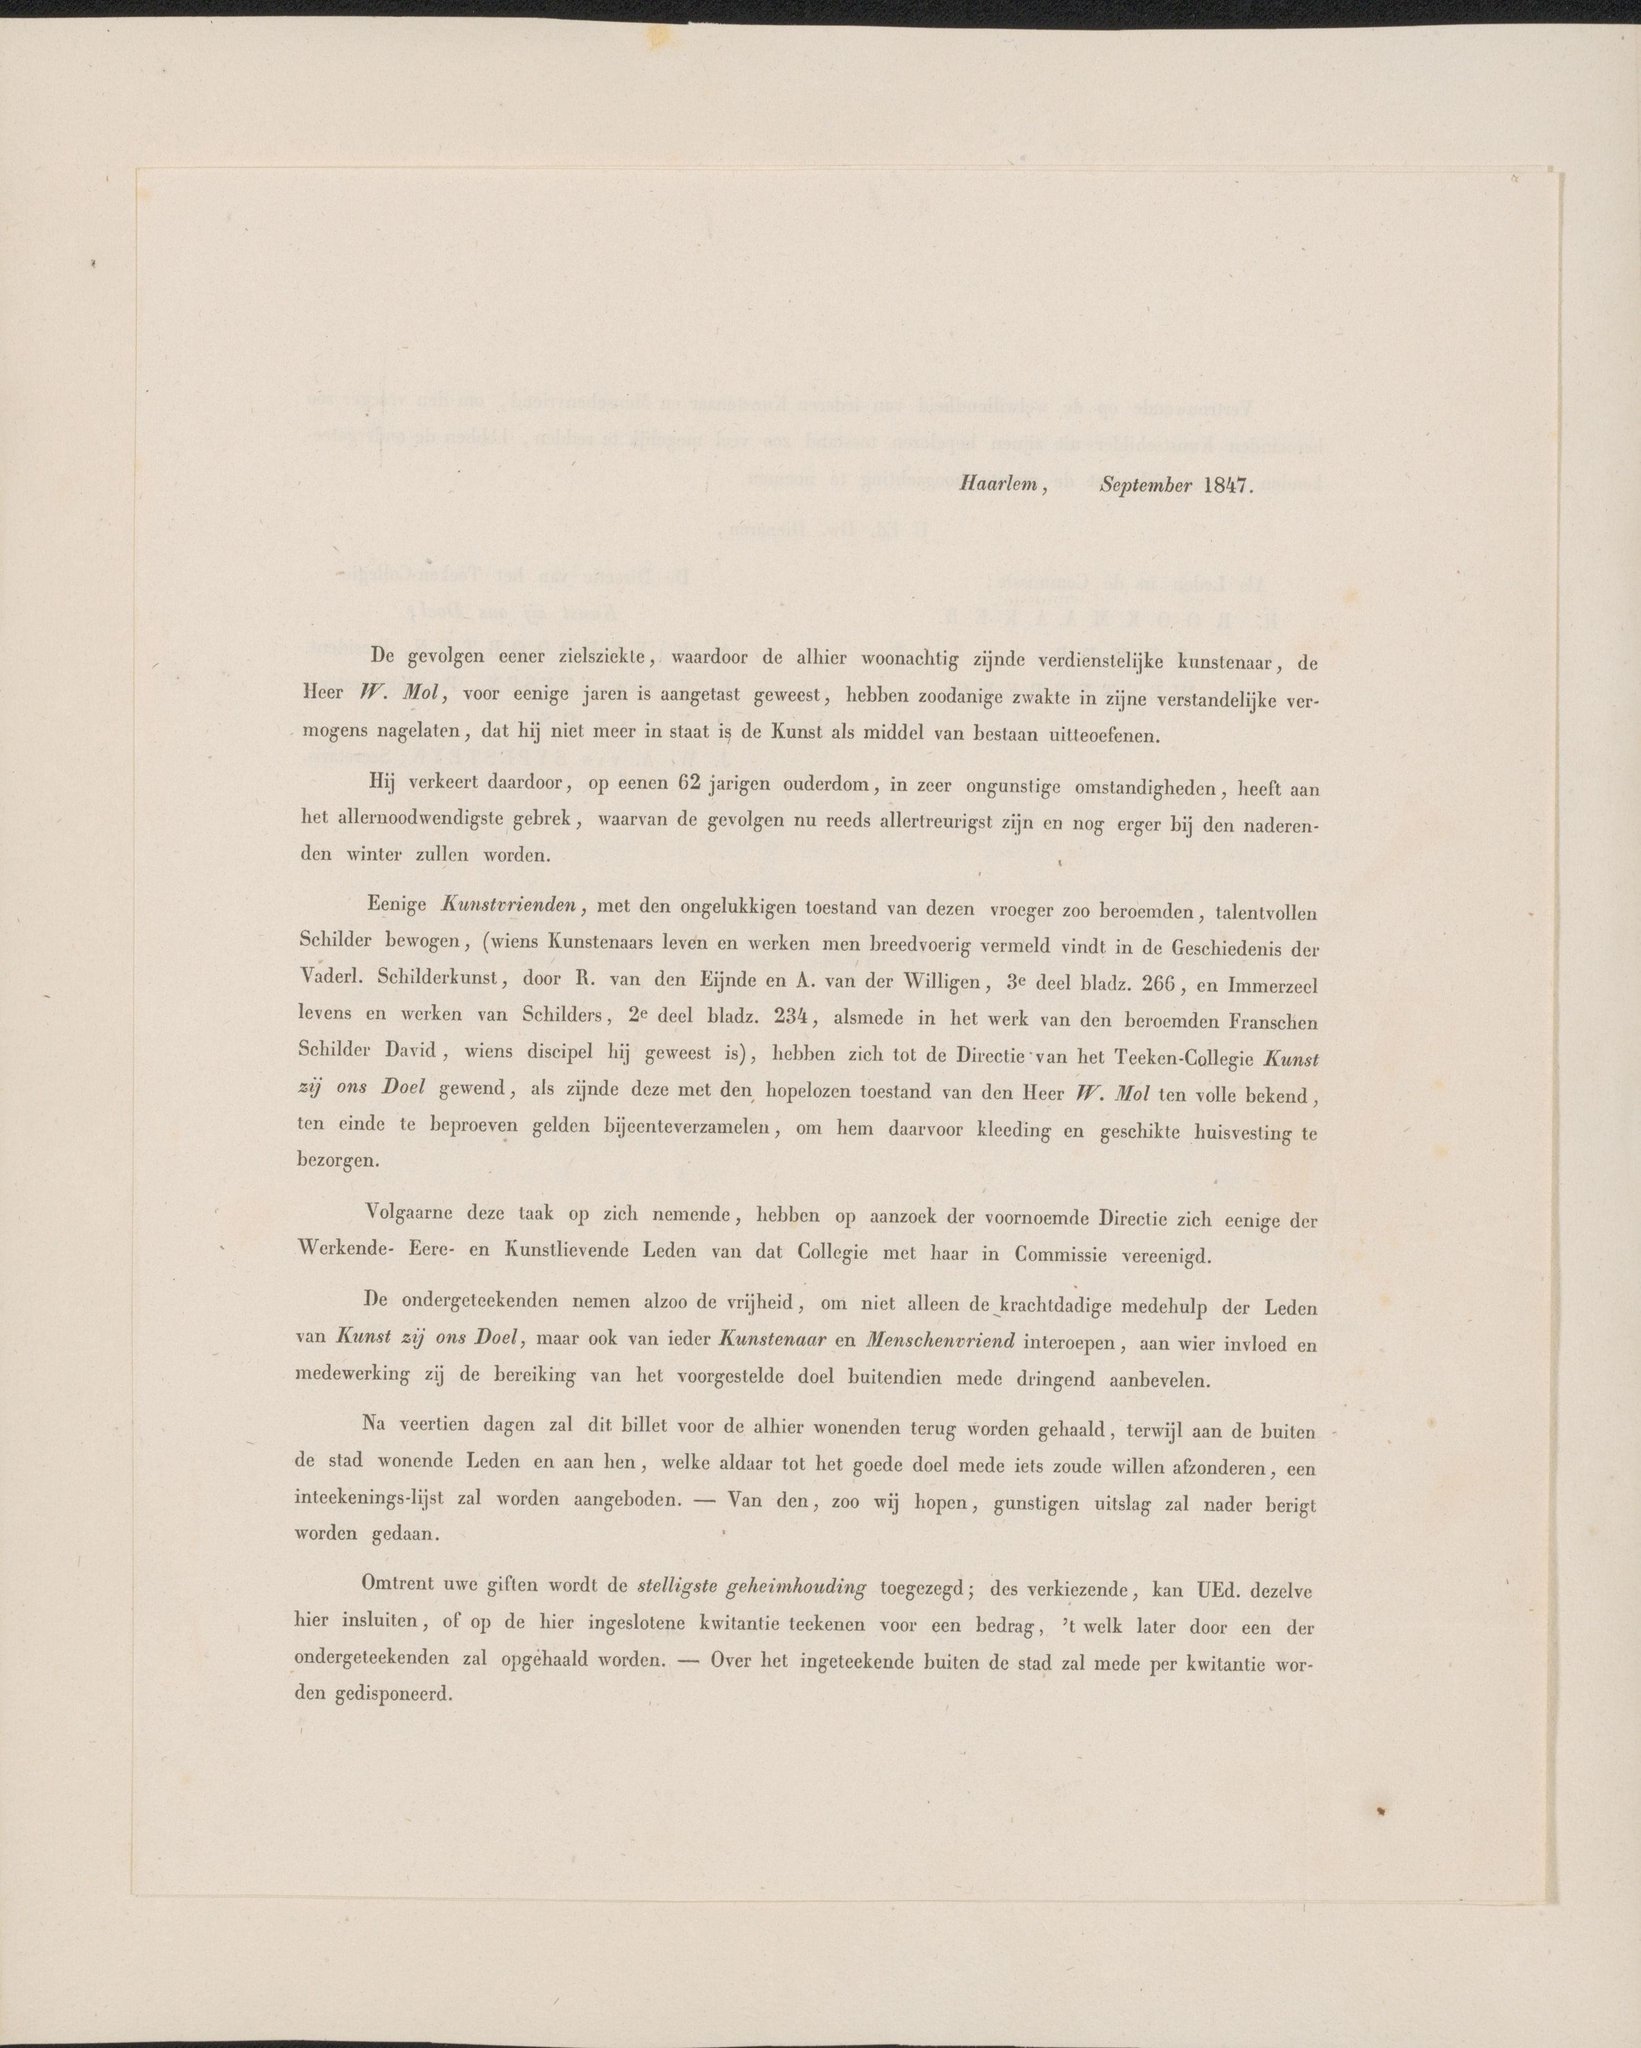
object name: letter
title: Circulaire betreffende Wouterus Mol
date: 1809-1847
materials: paper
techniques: printing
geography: haarlem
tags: haarlem, painter, draughtsman, woutherus mol, diseases, charitable works, money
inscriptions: collector's mark: Lugt 2233